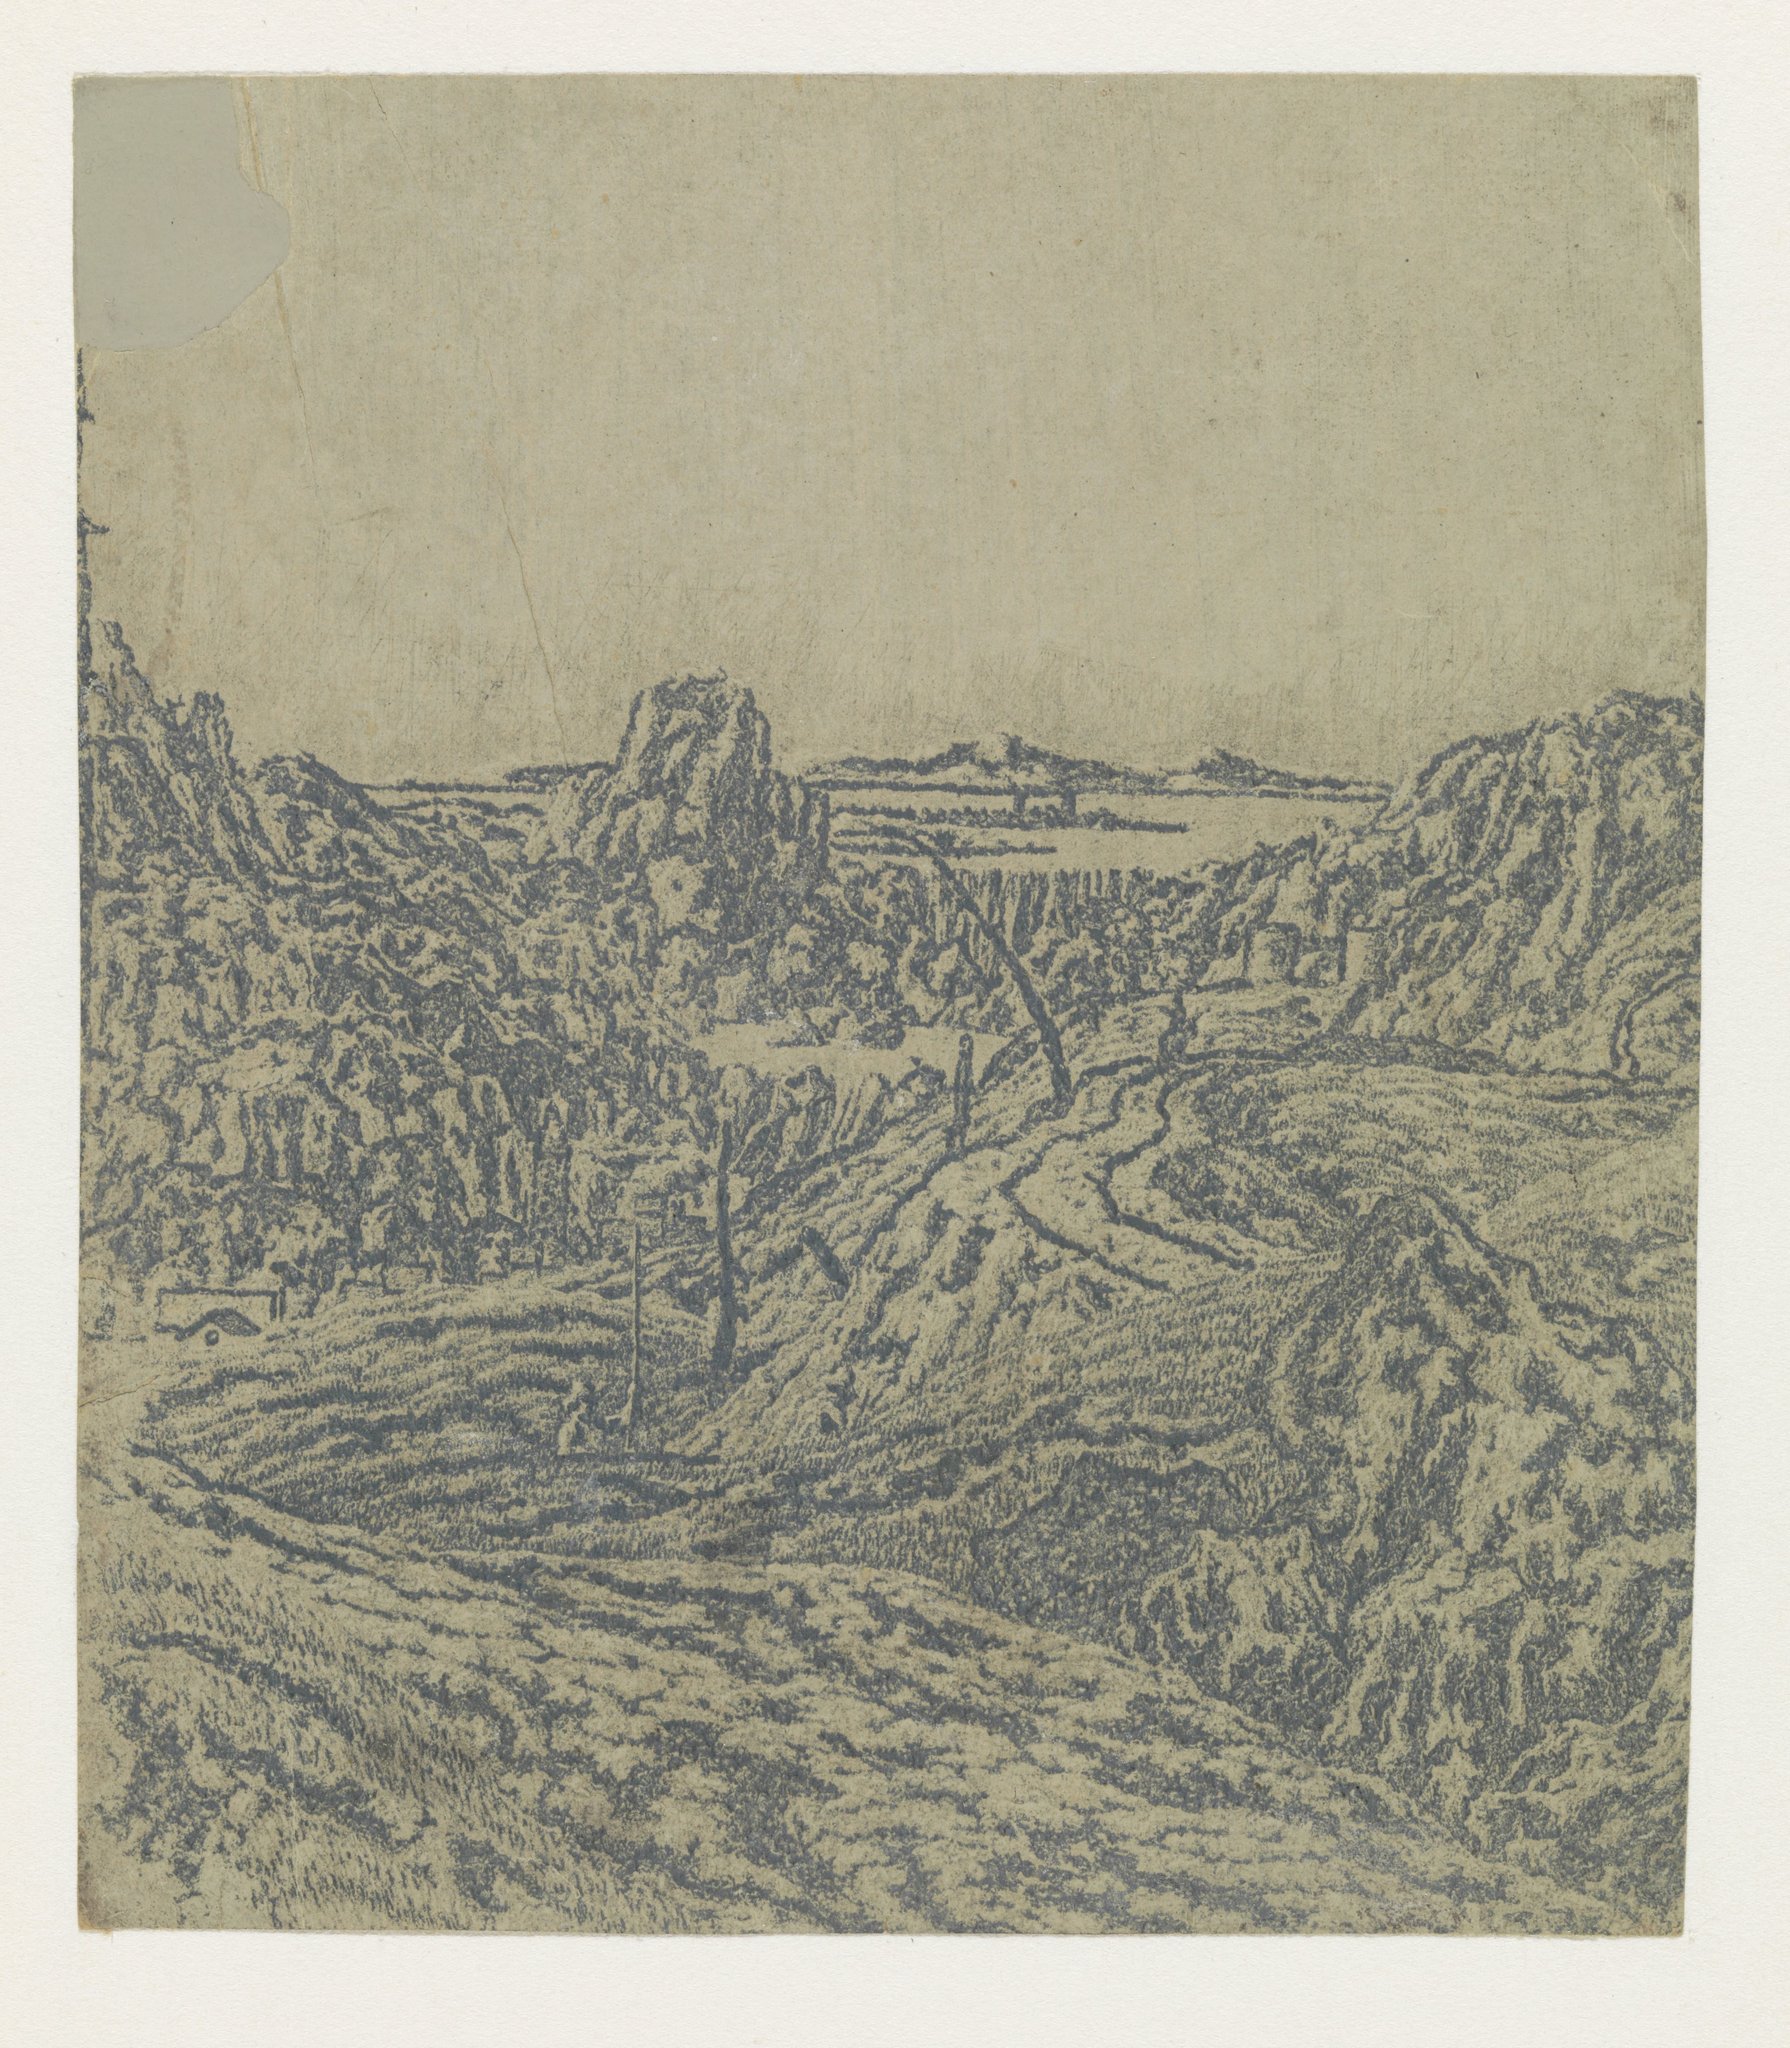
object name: print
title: Rocky Landscape with a Road Bordering a Gorge: Second Version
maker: hercules segers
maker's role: draughtsman, painter, print maker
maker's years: 1589-1640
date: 1625-1630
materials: paper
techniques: etching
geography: amsterdam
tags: sports, games ~ animals (+ spear), mountains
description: This etching is a variant of the print, two impressions of which are on view next to it (RP-P-1951-528, RP-P-H-OB-805). In contrast to the first version, this second one displays no traces of an earlier etching or other imperfections.